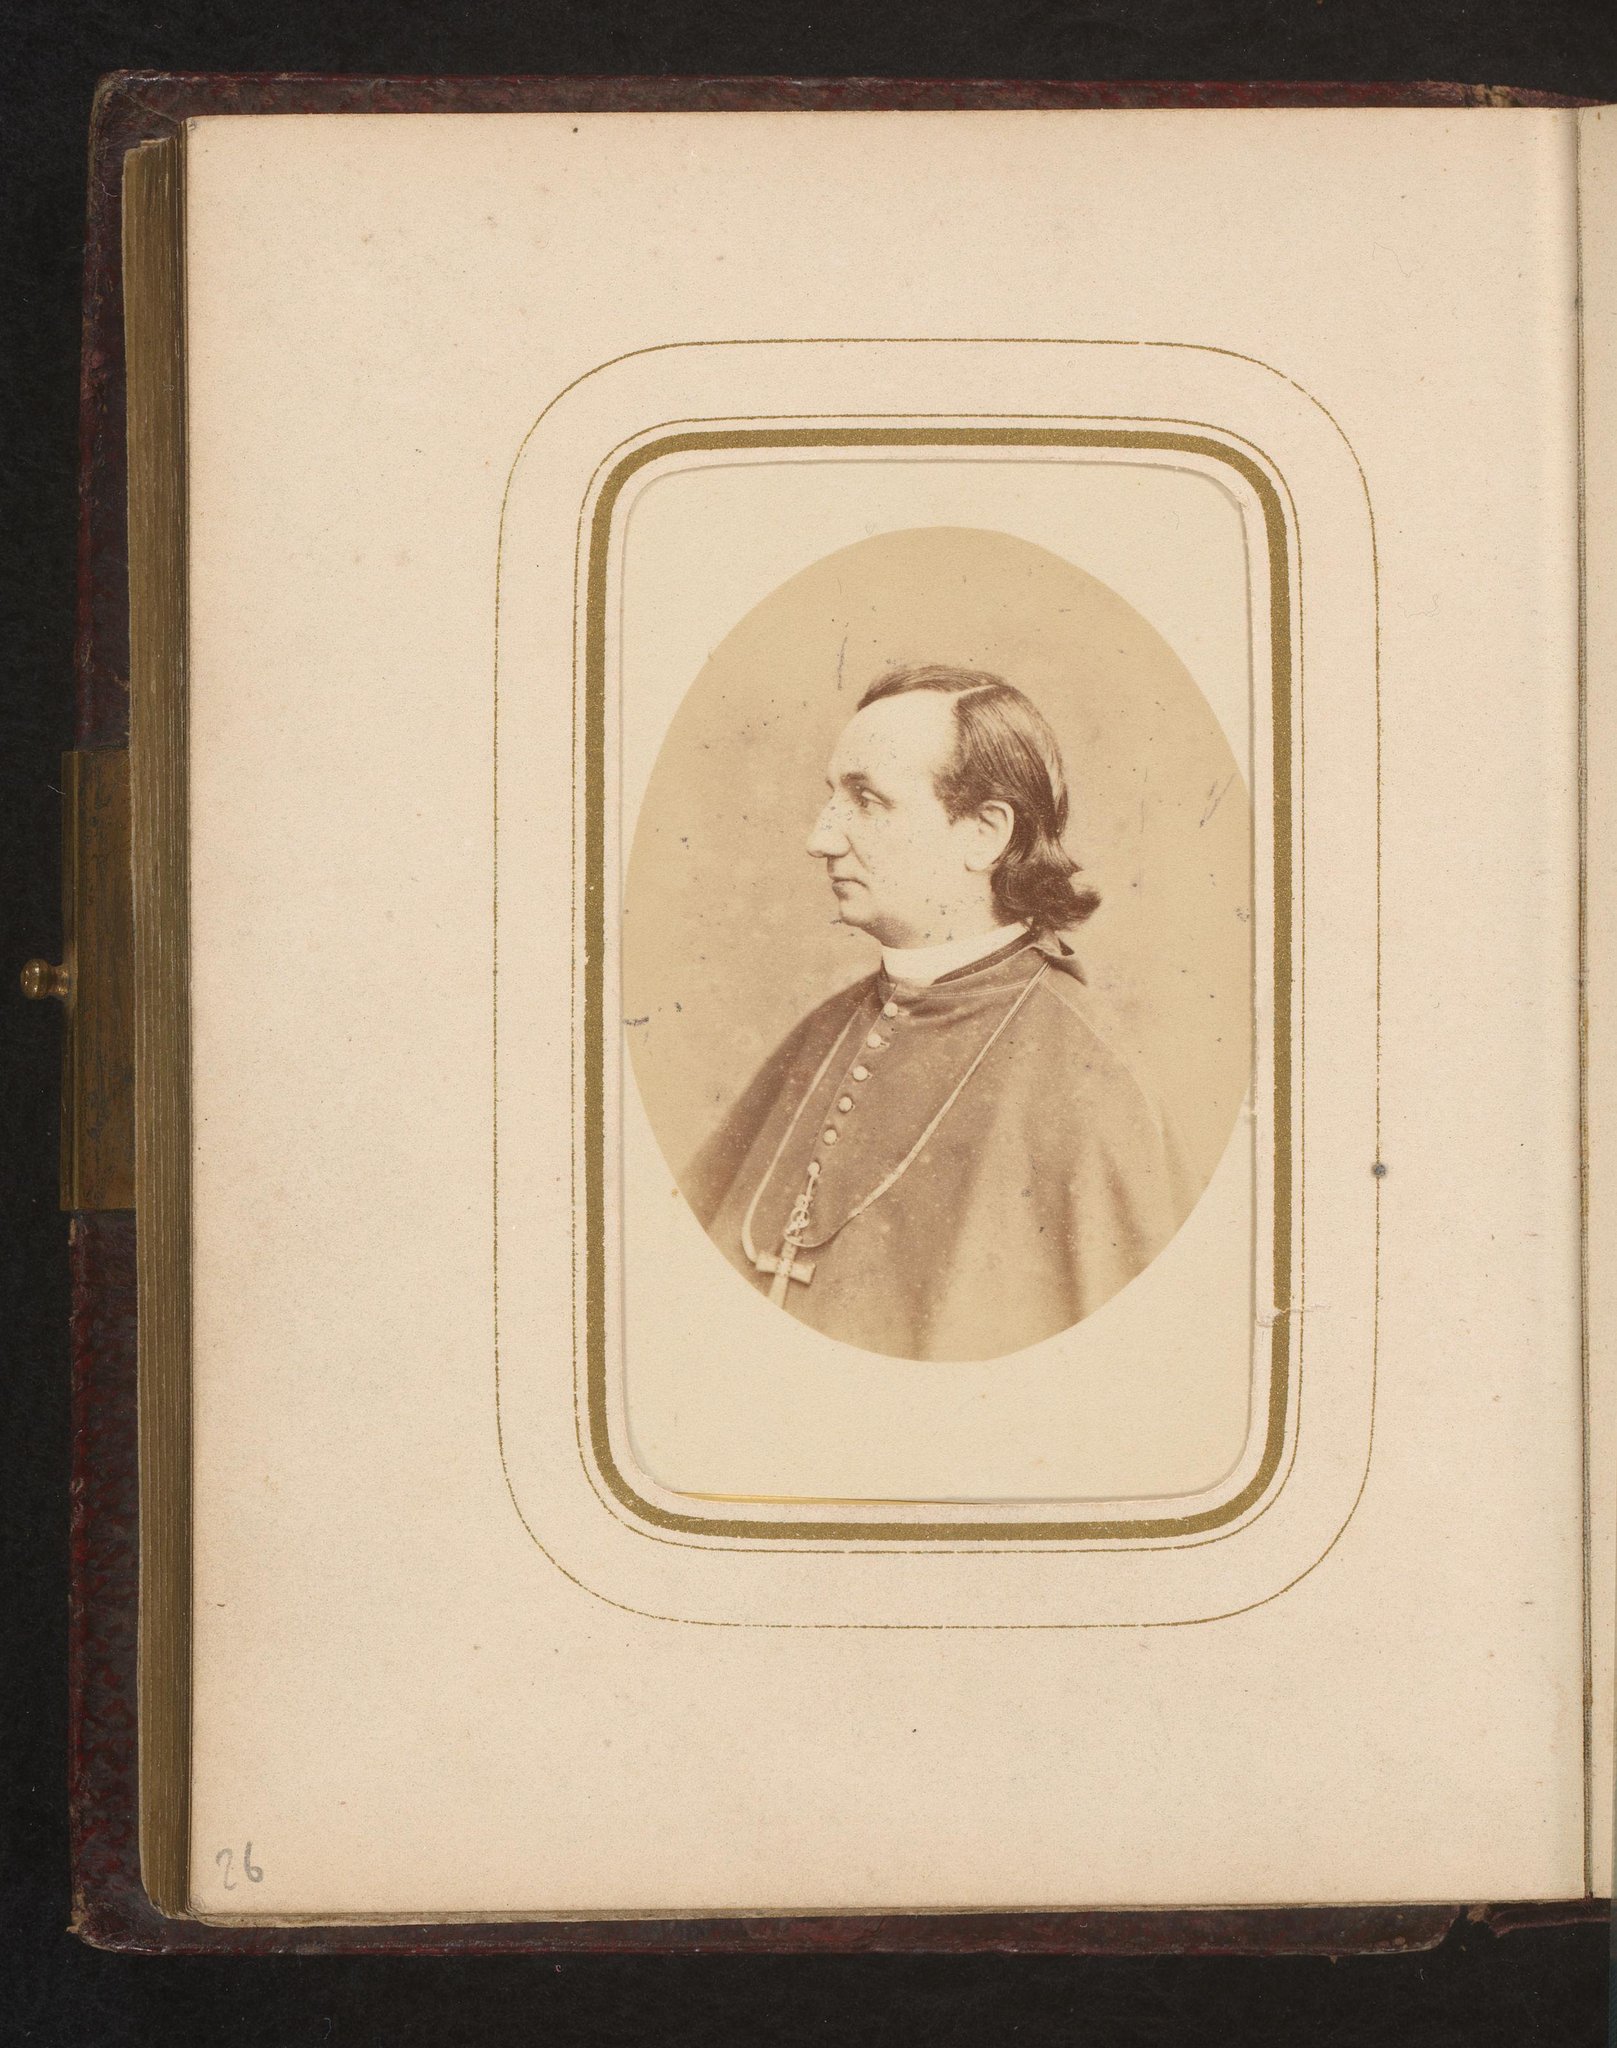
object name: album leaf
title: Portret van een geestelijke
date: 1860-1890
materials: cardboard, photographic support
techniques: albumen print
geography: geneva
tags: historical persons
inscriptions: inscription: ‘Atelier Faedo/ Temporèl Succcr./ Chemin Dancet & Rue Masbou/ Plainpalais/ Genève’